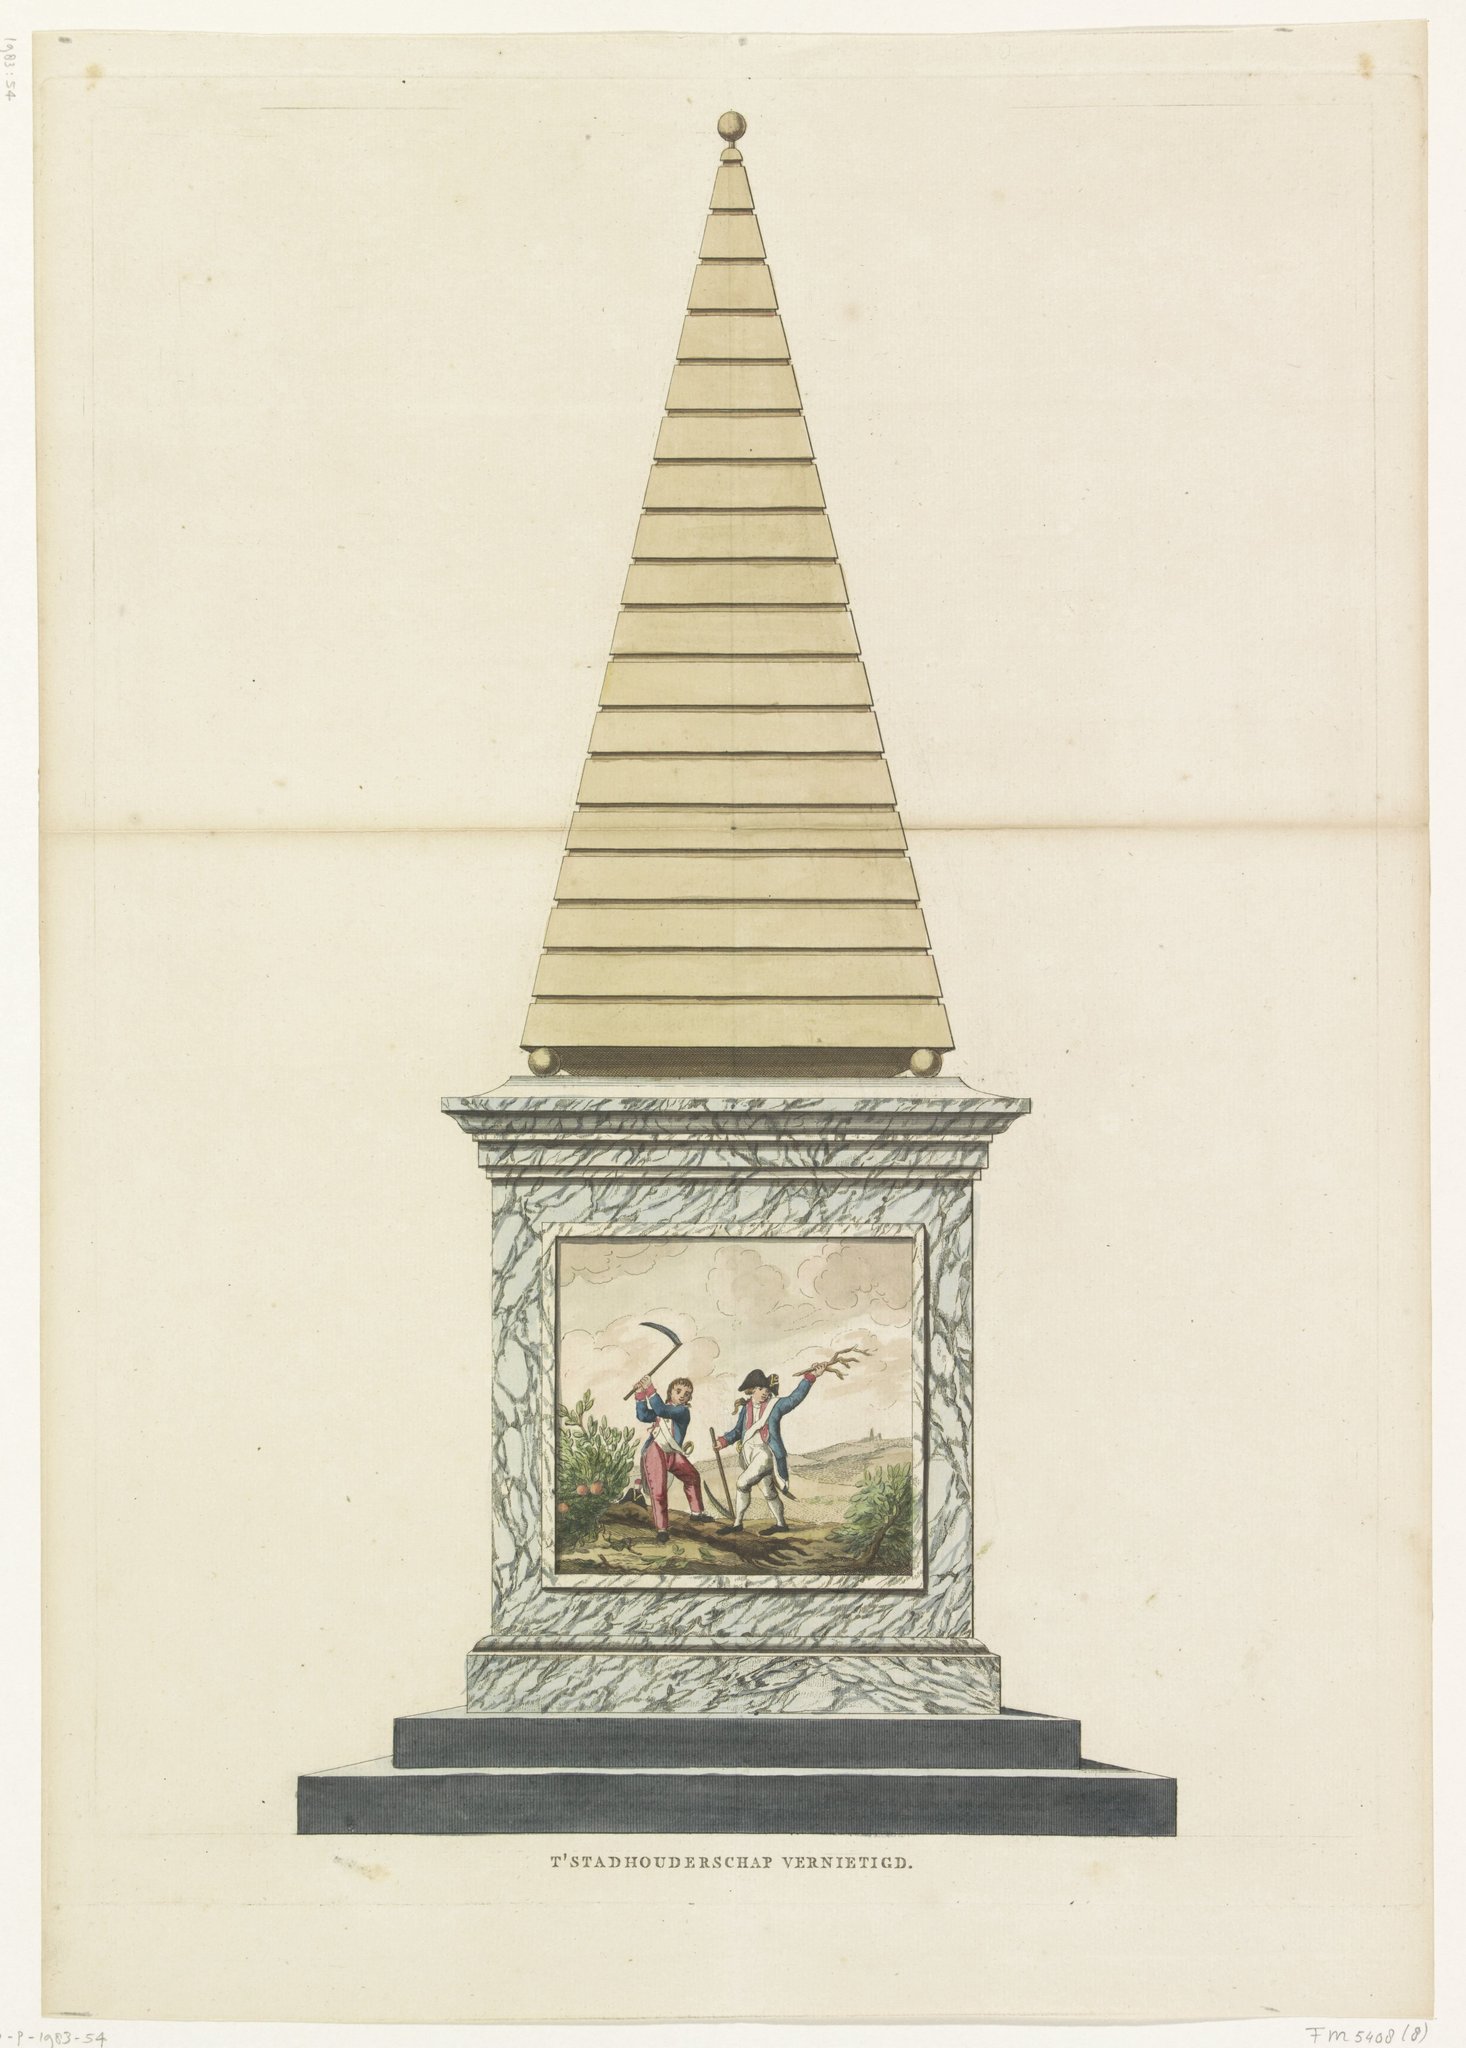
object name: print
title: Vijftien decoraties bij het Alliantiefeest te Amsterdam in 1795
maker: Anonymous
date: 1795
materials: paper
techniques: etching, hand coloring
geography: netherlands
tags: woodcutting, woodcutter ~ forestry, festivities on events of national importance (+ festive decoration ~ festive activities), amsterdam, alliance with france (1795)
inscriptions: collector's mark: Lugt 2760, collector's mark: Lugt 2228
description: De Vernietiging van het stadhouderschap, allegorische decoratie opgericht in de Plantage te Amsterdam bij het Alliantiefeest op 19 juni 1795. Piramide met een voetsuk waarop een chassinet met voorstelling van een Bataaf en een Fransman die de Oranjeboom omhakken.